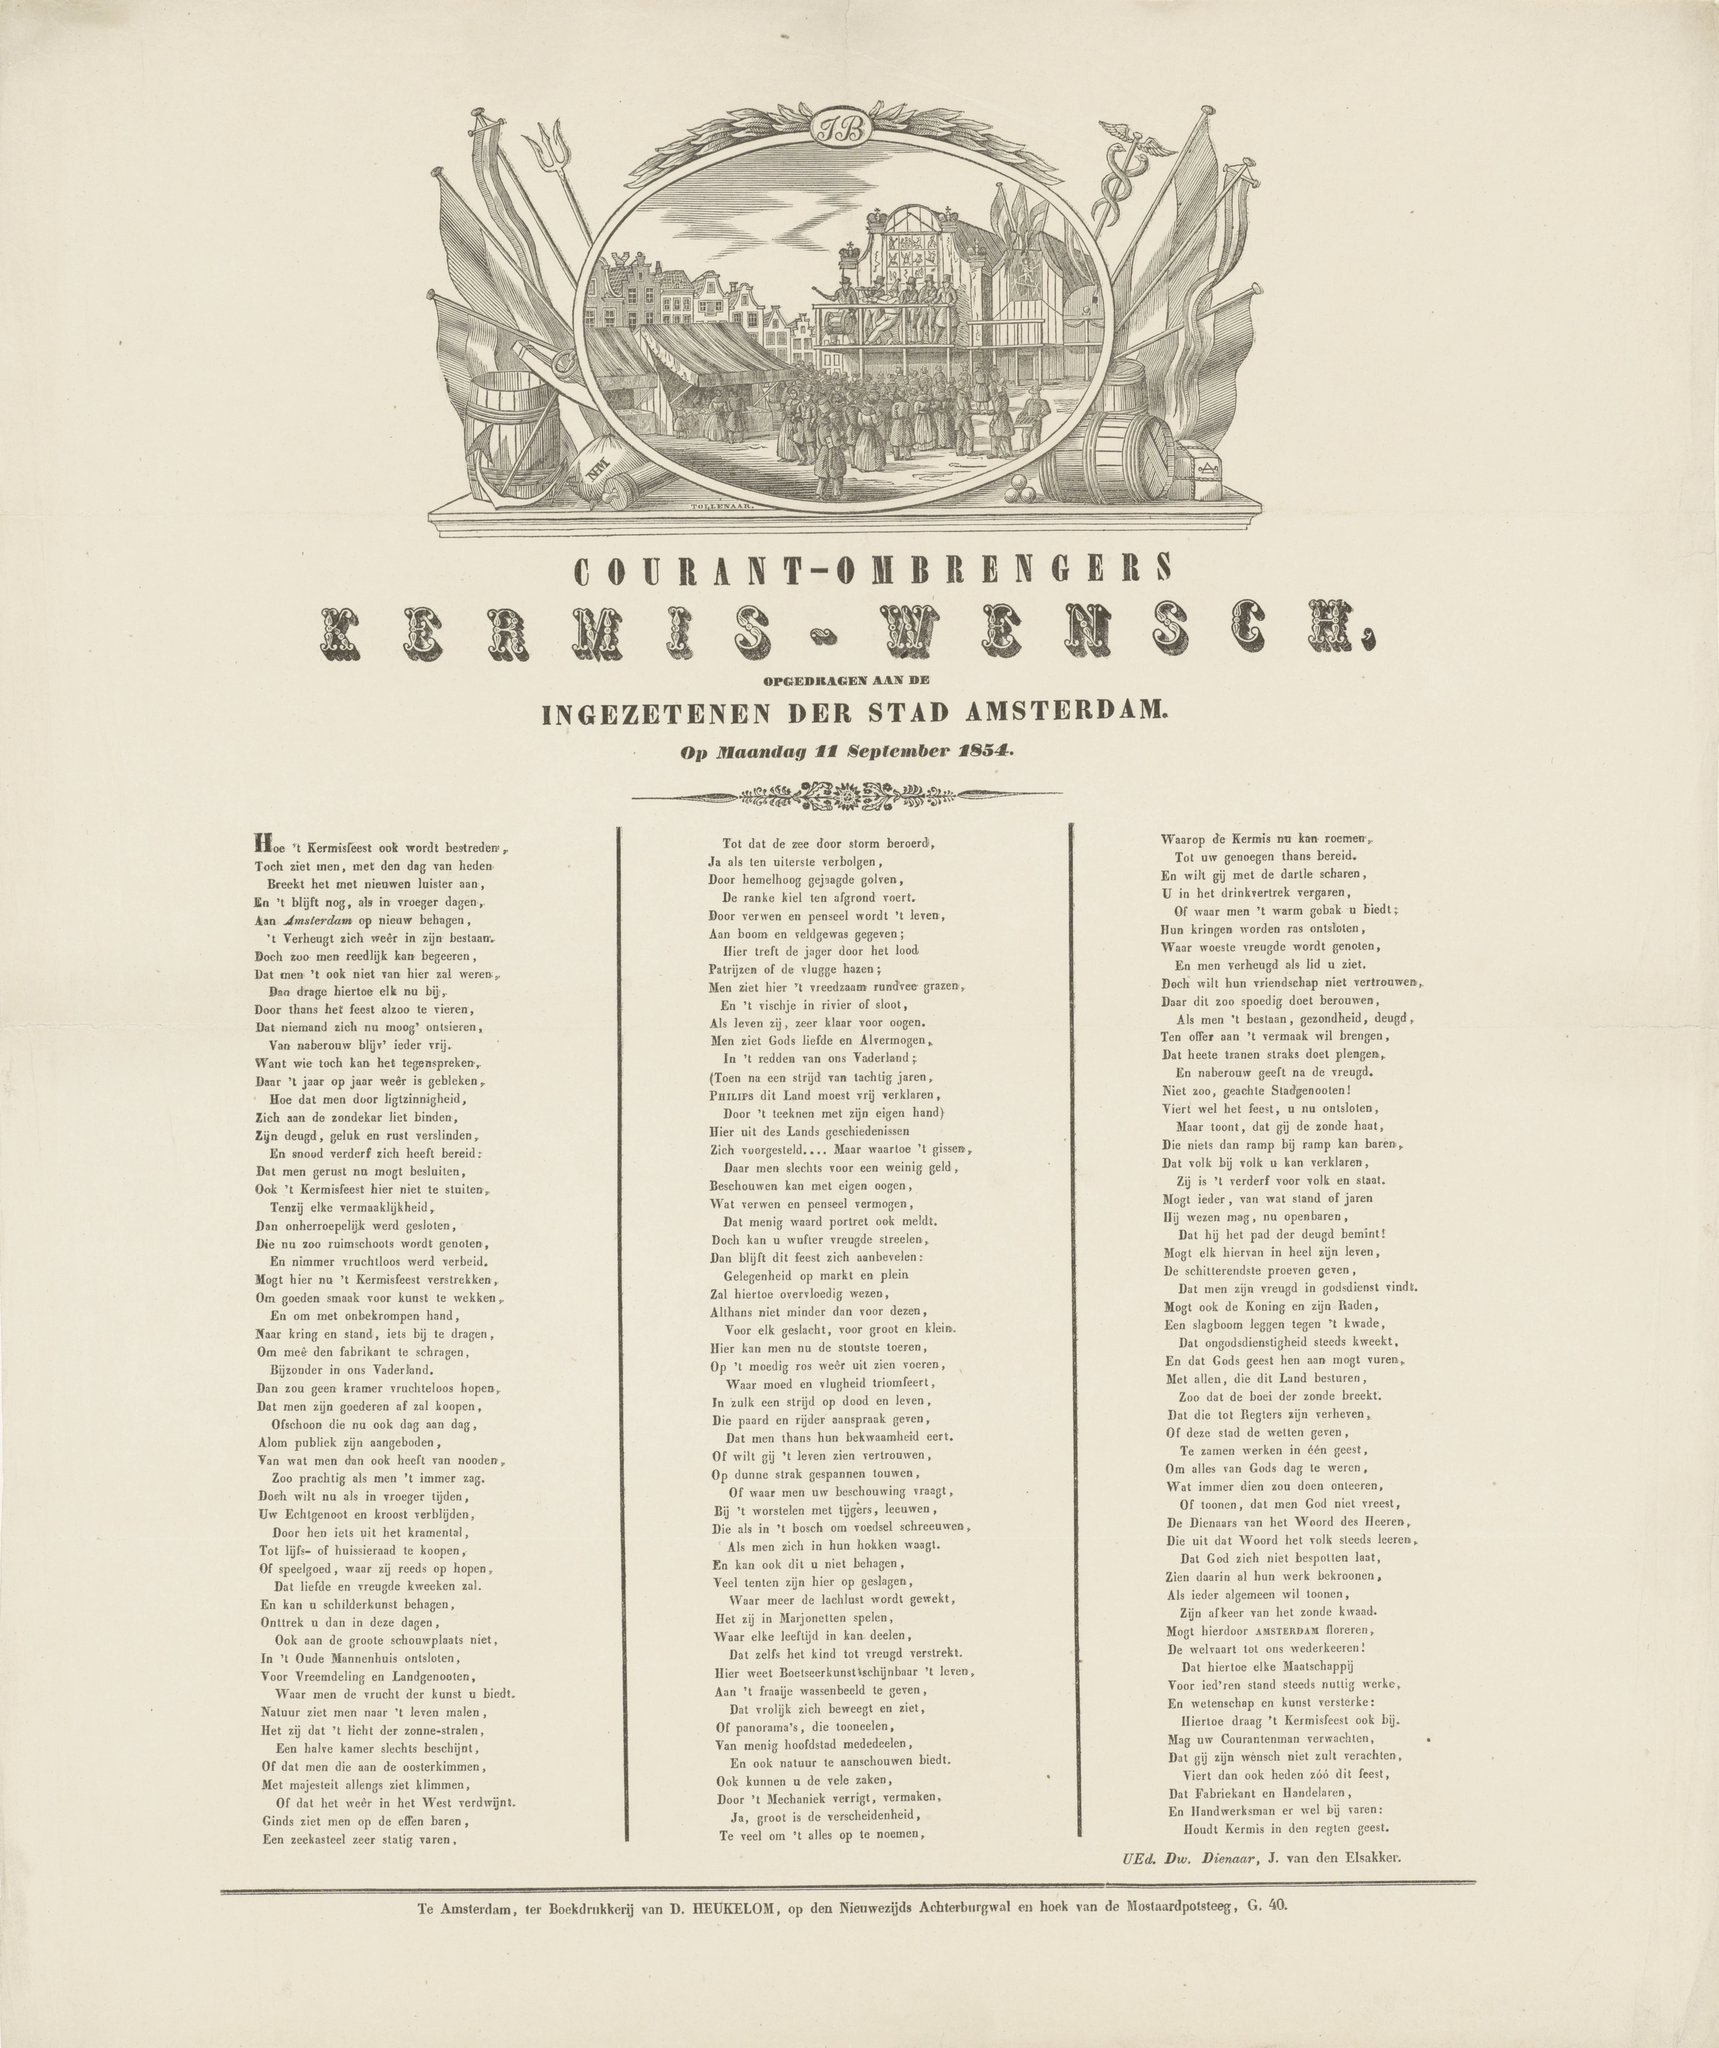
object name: fair print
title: Courant-Ombrengers Kermis-Wensch (...) 1854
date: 1854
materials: paper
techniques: letterpress printing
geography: amsterdam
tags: pleasure fair and circus, amsterdam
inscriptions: collector's mark: Lugt 2228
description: Kermisprent namens de ombrengers van couranten (krantenbezorgers) te Amsterdam, 11 september 1854. Bovenaan een medaillon met een gezicht op de kermis op de Botermarkt. Onderaan een gedicht in drie kolommen. Van de courantombrenger: J. van den Elsakker.